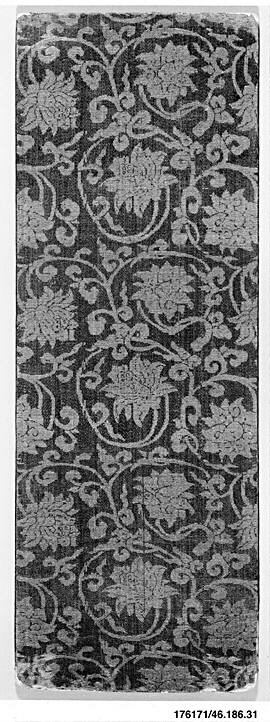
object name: sutra cover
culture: chinese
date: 1501-1600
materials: silk